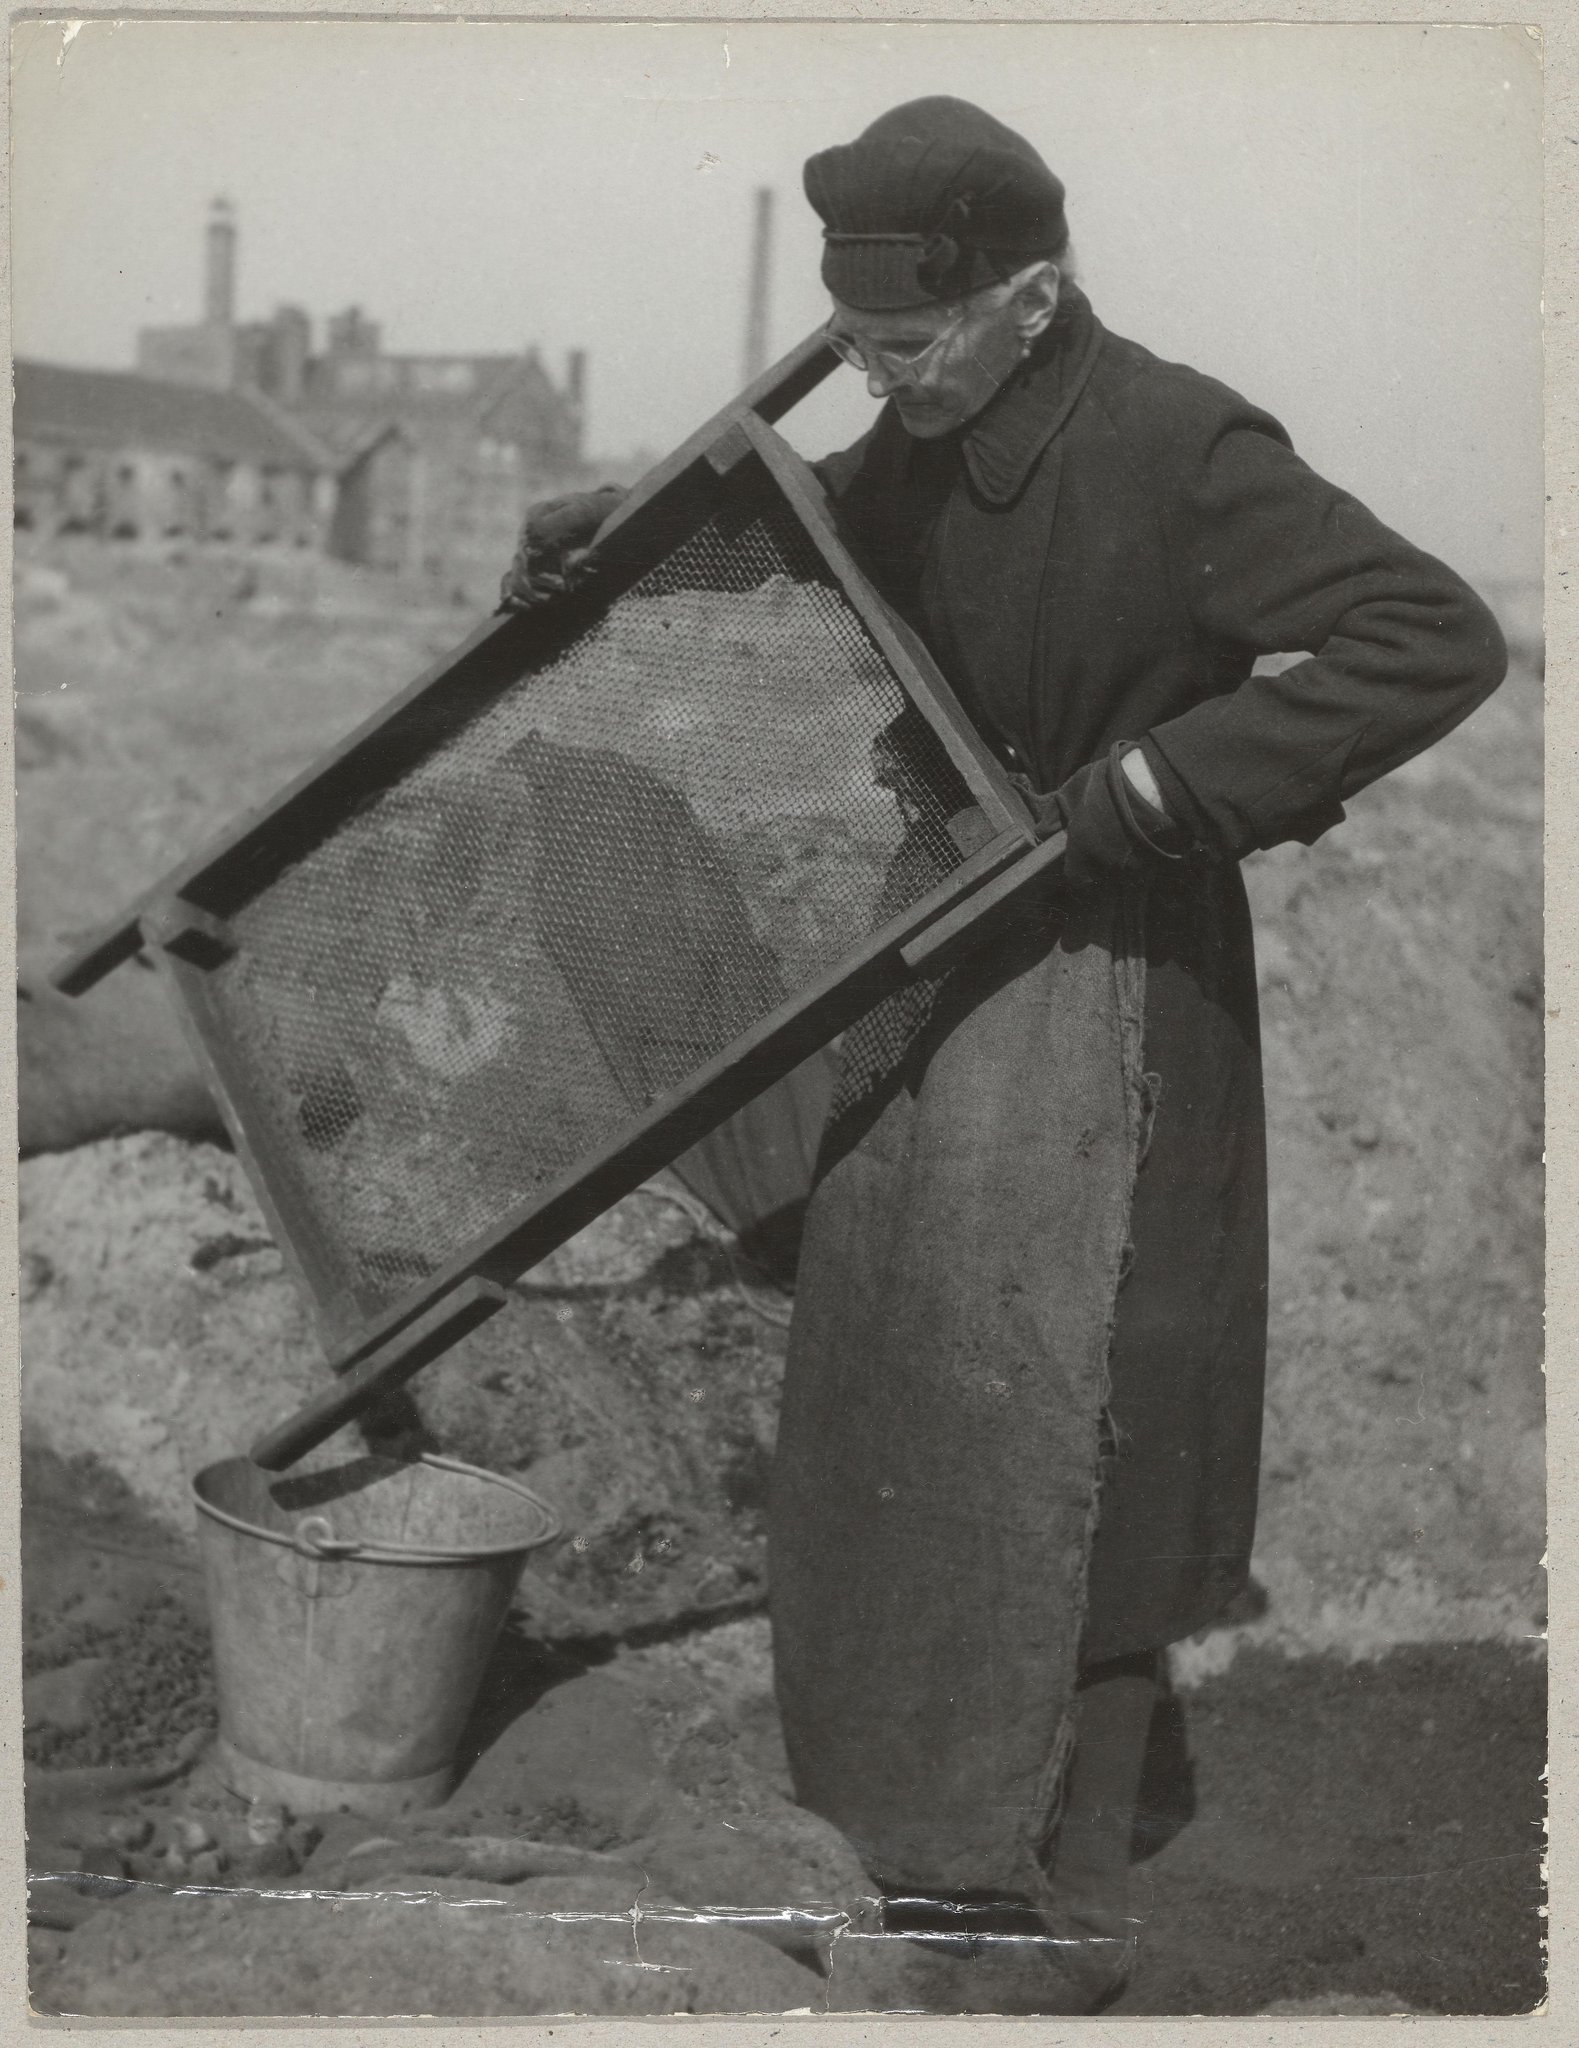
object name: photograph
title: Vrouw zoekt kolen tijdens de Hongerwinter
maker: emmy eugenie andriesse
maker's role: fotograaf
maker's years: 1914-1953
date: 1930-1950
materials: paper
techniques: gelatin silver print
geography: amsterdam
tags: coal-bucket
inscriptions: annotation: ‘WO II NEDERLAND’, annotation: ‘Archief exemplaar Na publicatie gelieve te retourneren aan ABC Press, Amsterdam-c n.z. voorburgwal’, annotation: ‘Emmy Andriesse, Amsterdam-c o.z. achterburgwal 192’